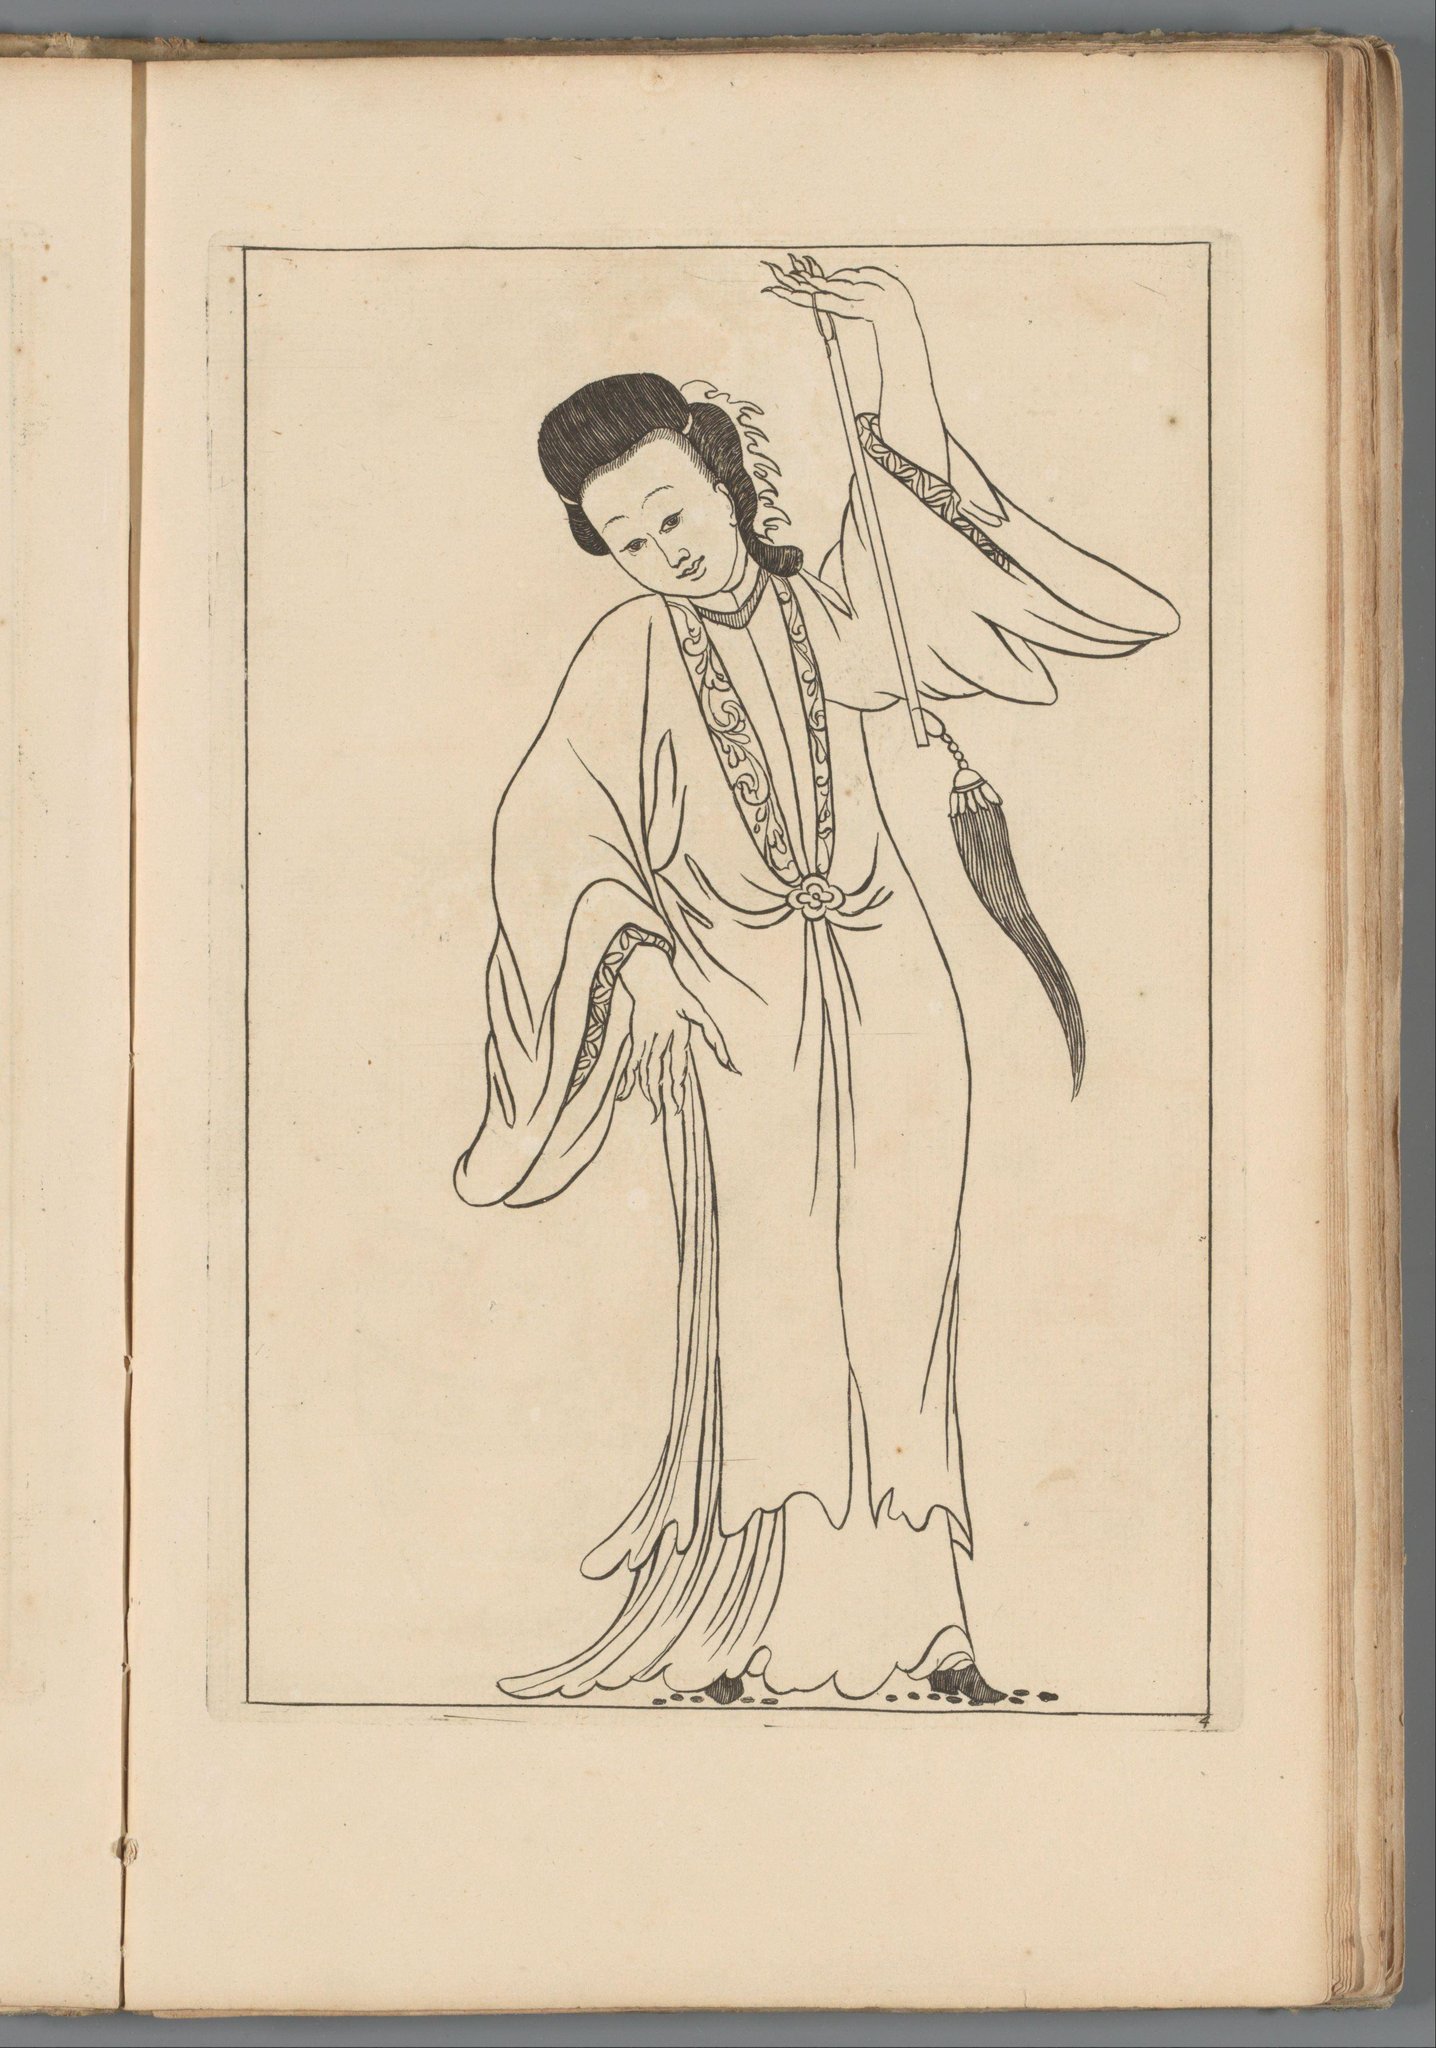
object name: ornament print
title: Staande Chinese vrouw met attribuut in de linkerhand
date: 1727-1775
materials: paper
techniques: etching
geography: amsterdam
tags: chinese (+ women), chinese (+ costume)